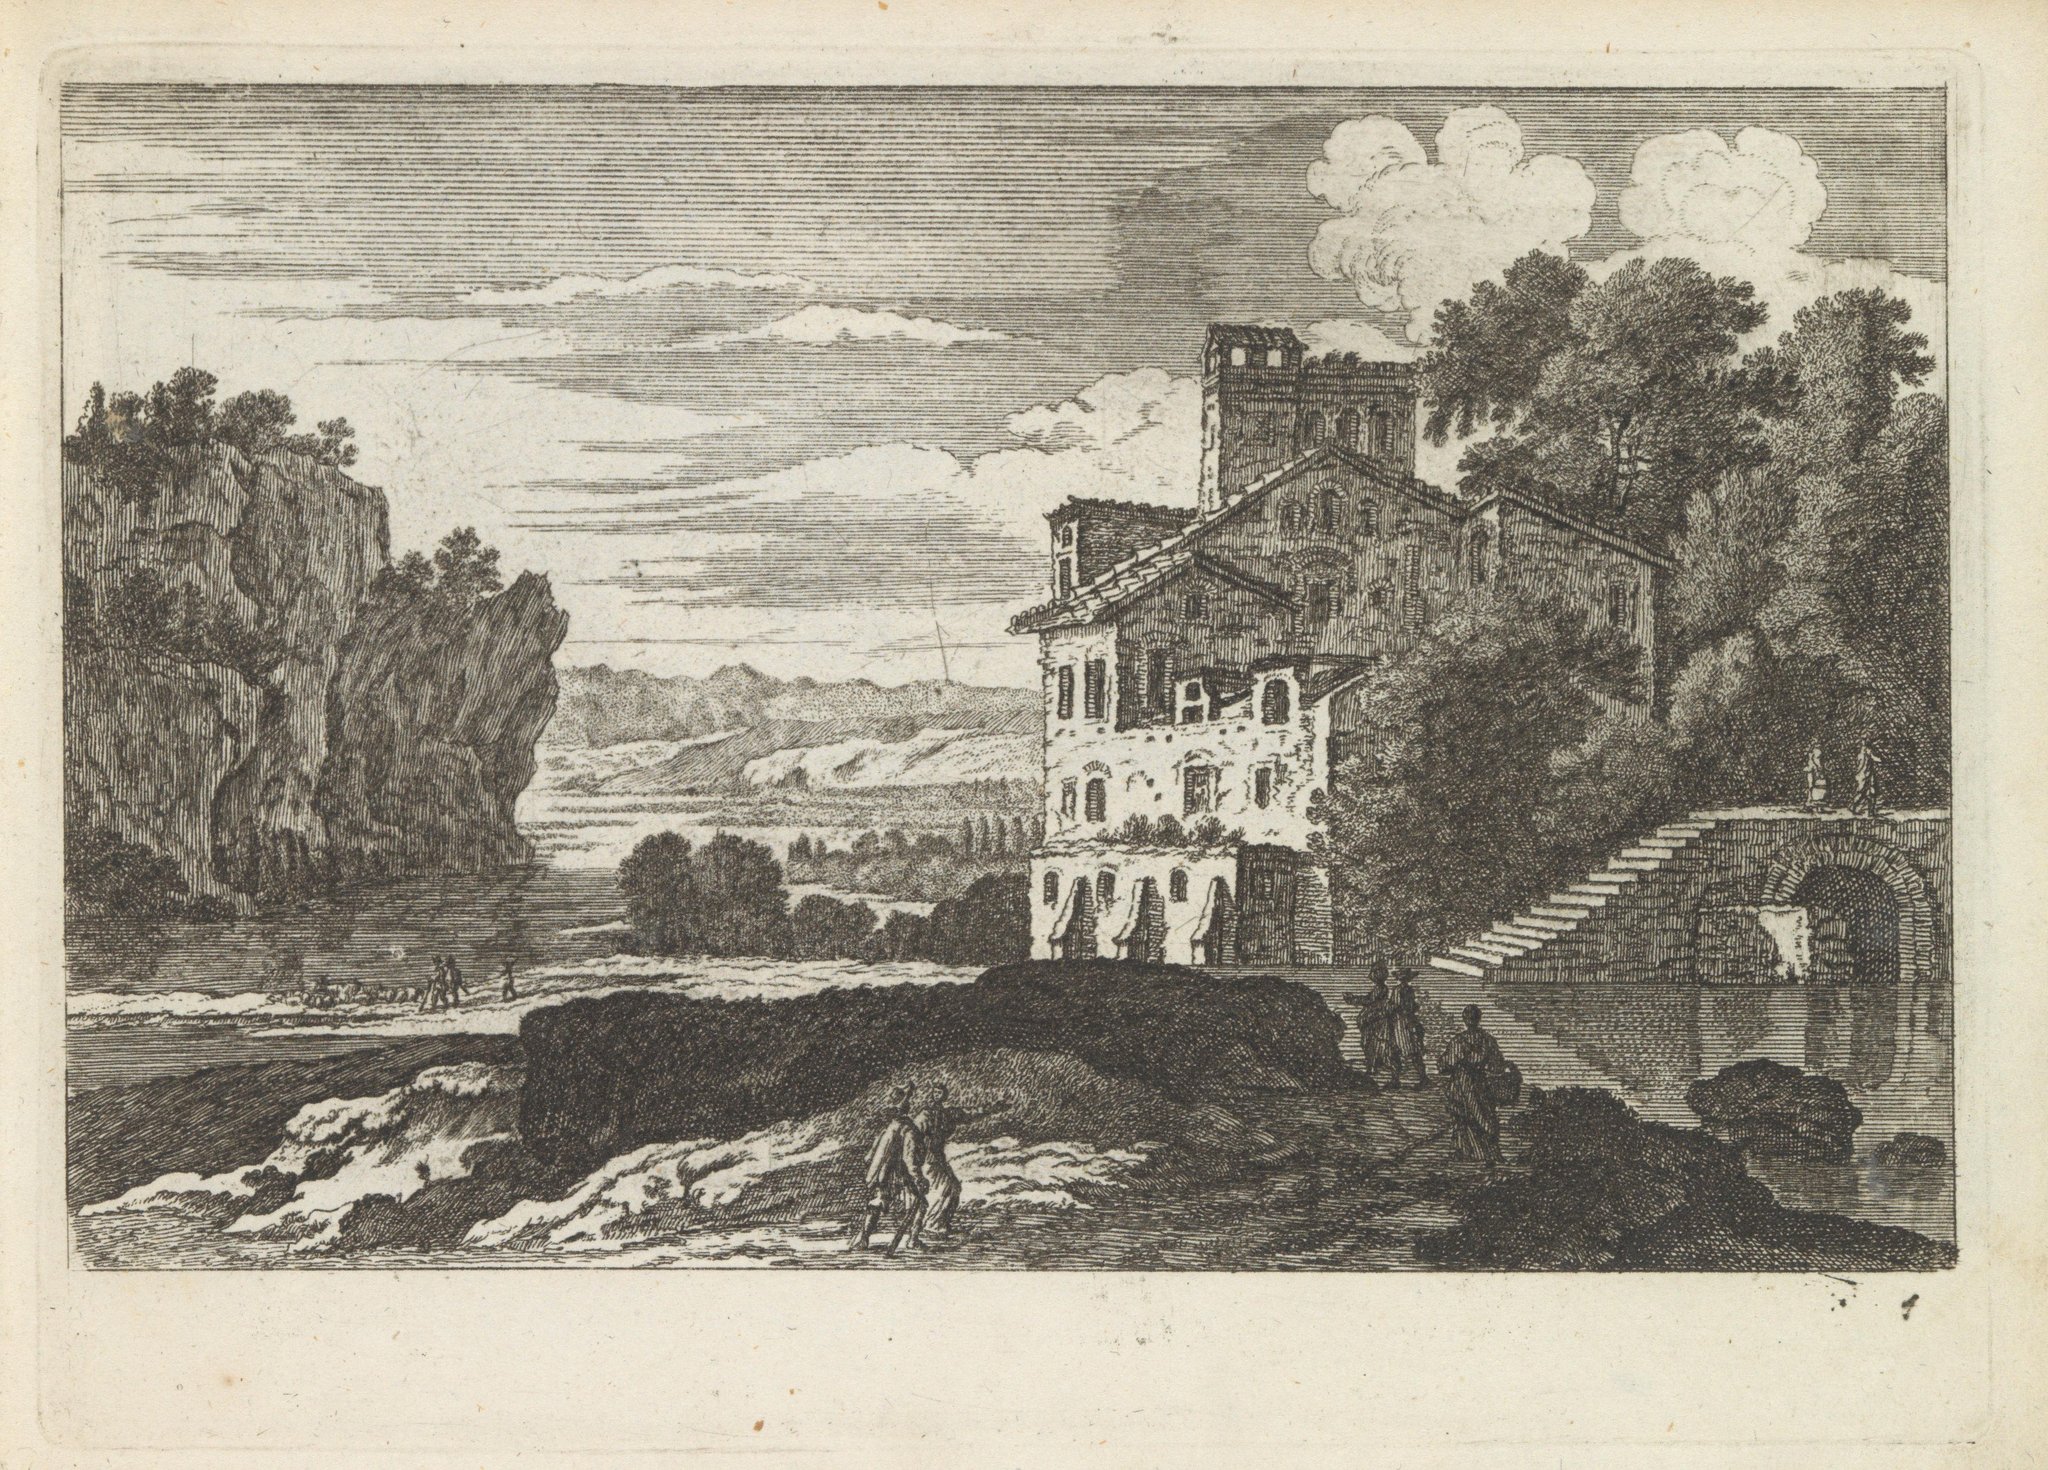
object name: print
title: Spiegel der natuur en school der teekenkunde (...)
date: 1641-1695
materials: paper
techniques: etching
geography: amsterdam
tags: landscapes in the temperate zone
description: Landschap met rechts een groot bouwsel. De trap ernaast loopt af in het water. Links een rotswand. Rechtsonder genummerd: 1. De prent maakt deel uit van een album.